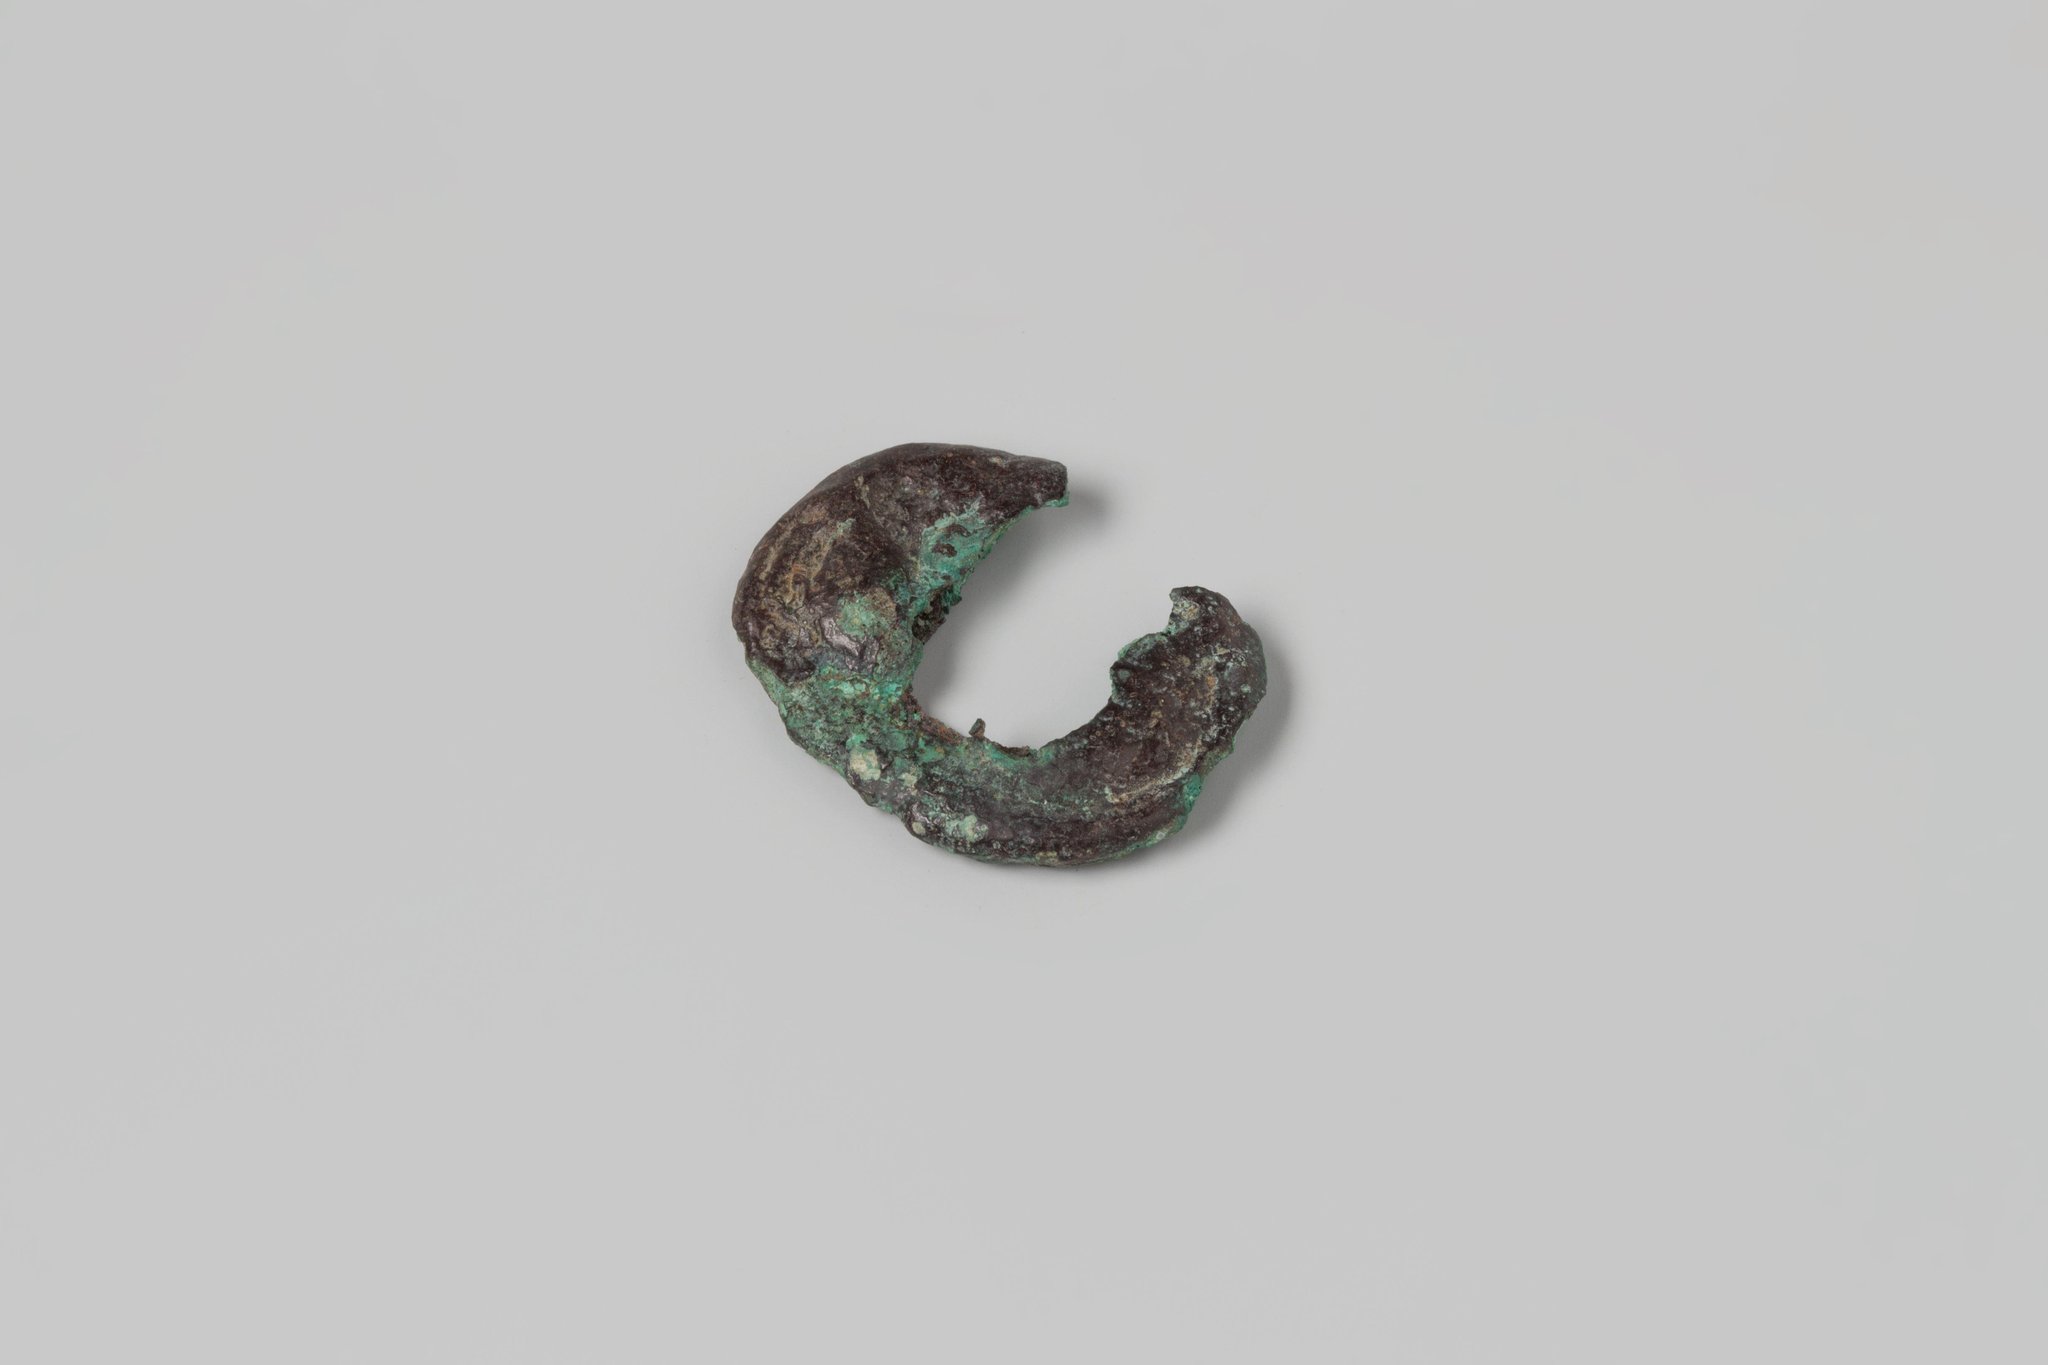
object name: fragment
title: Fragment koper uit het wrak van de Oost-Indiëvaarder Hollandia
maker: Anonymous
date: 1700-1743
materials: copper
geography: netherlands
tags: verenigde oostindische compagnie, hollandia (schip), annet